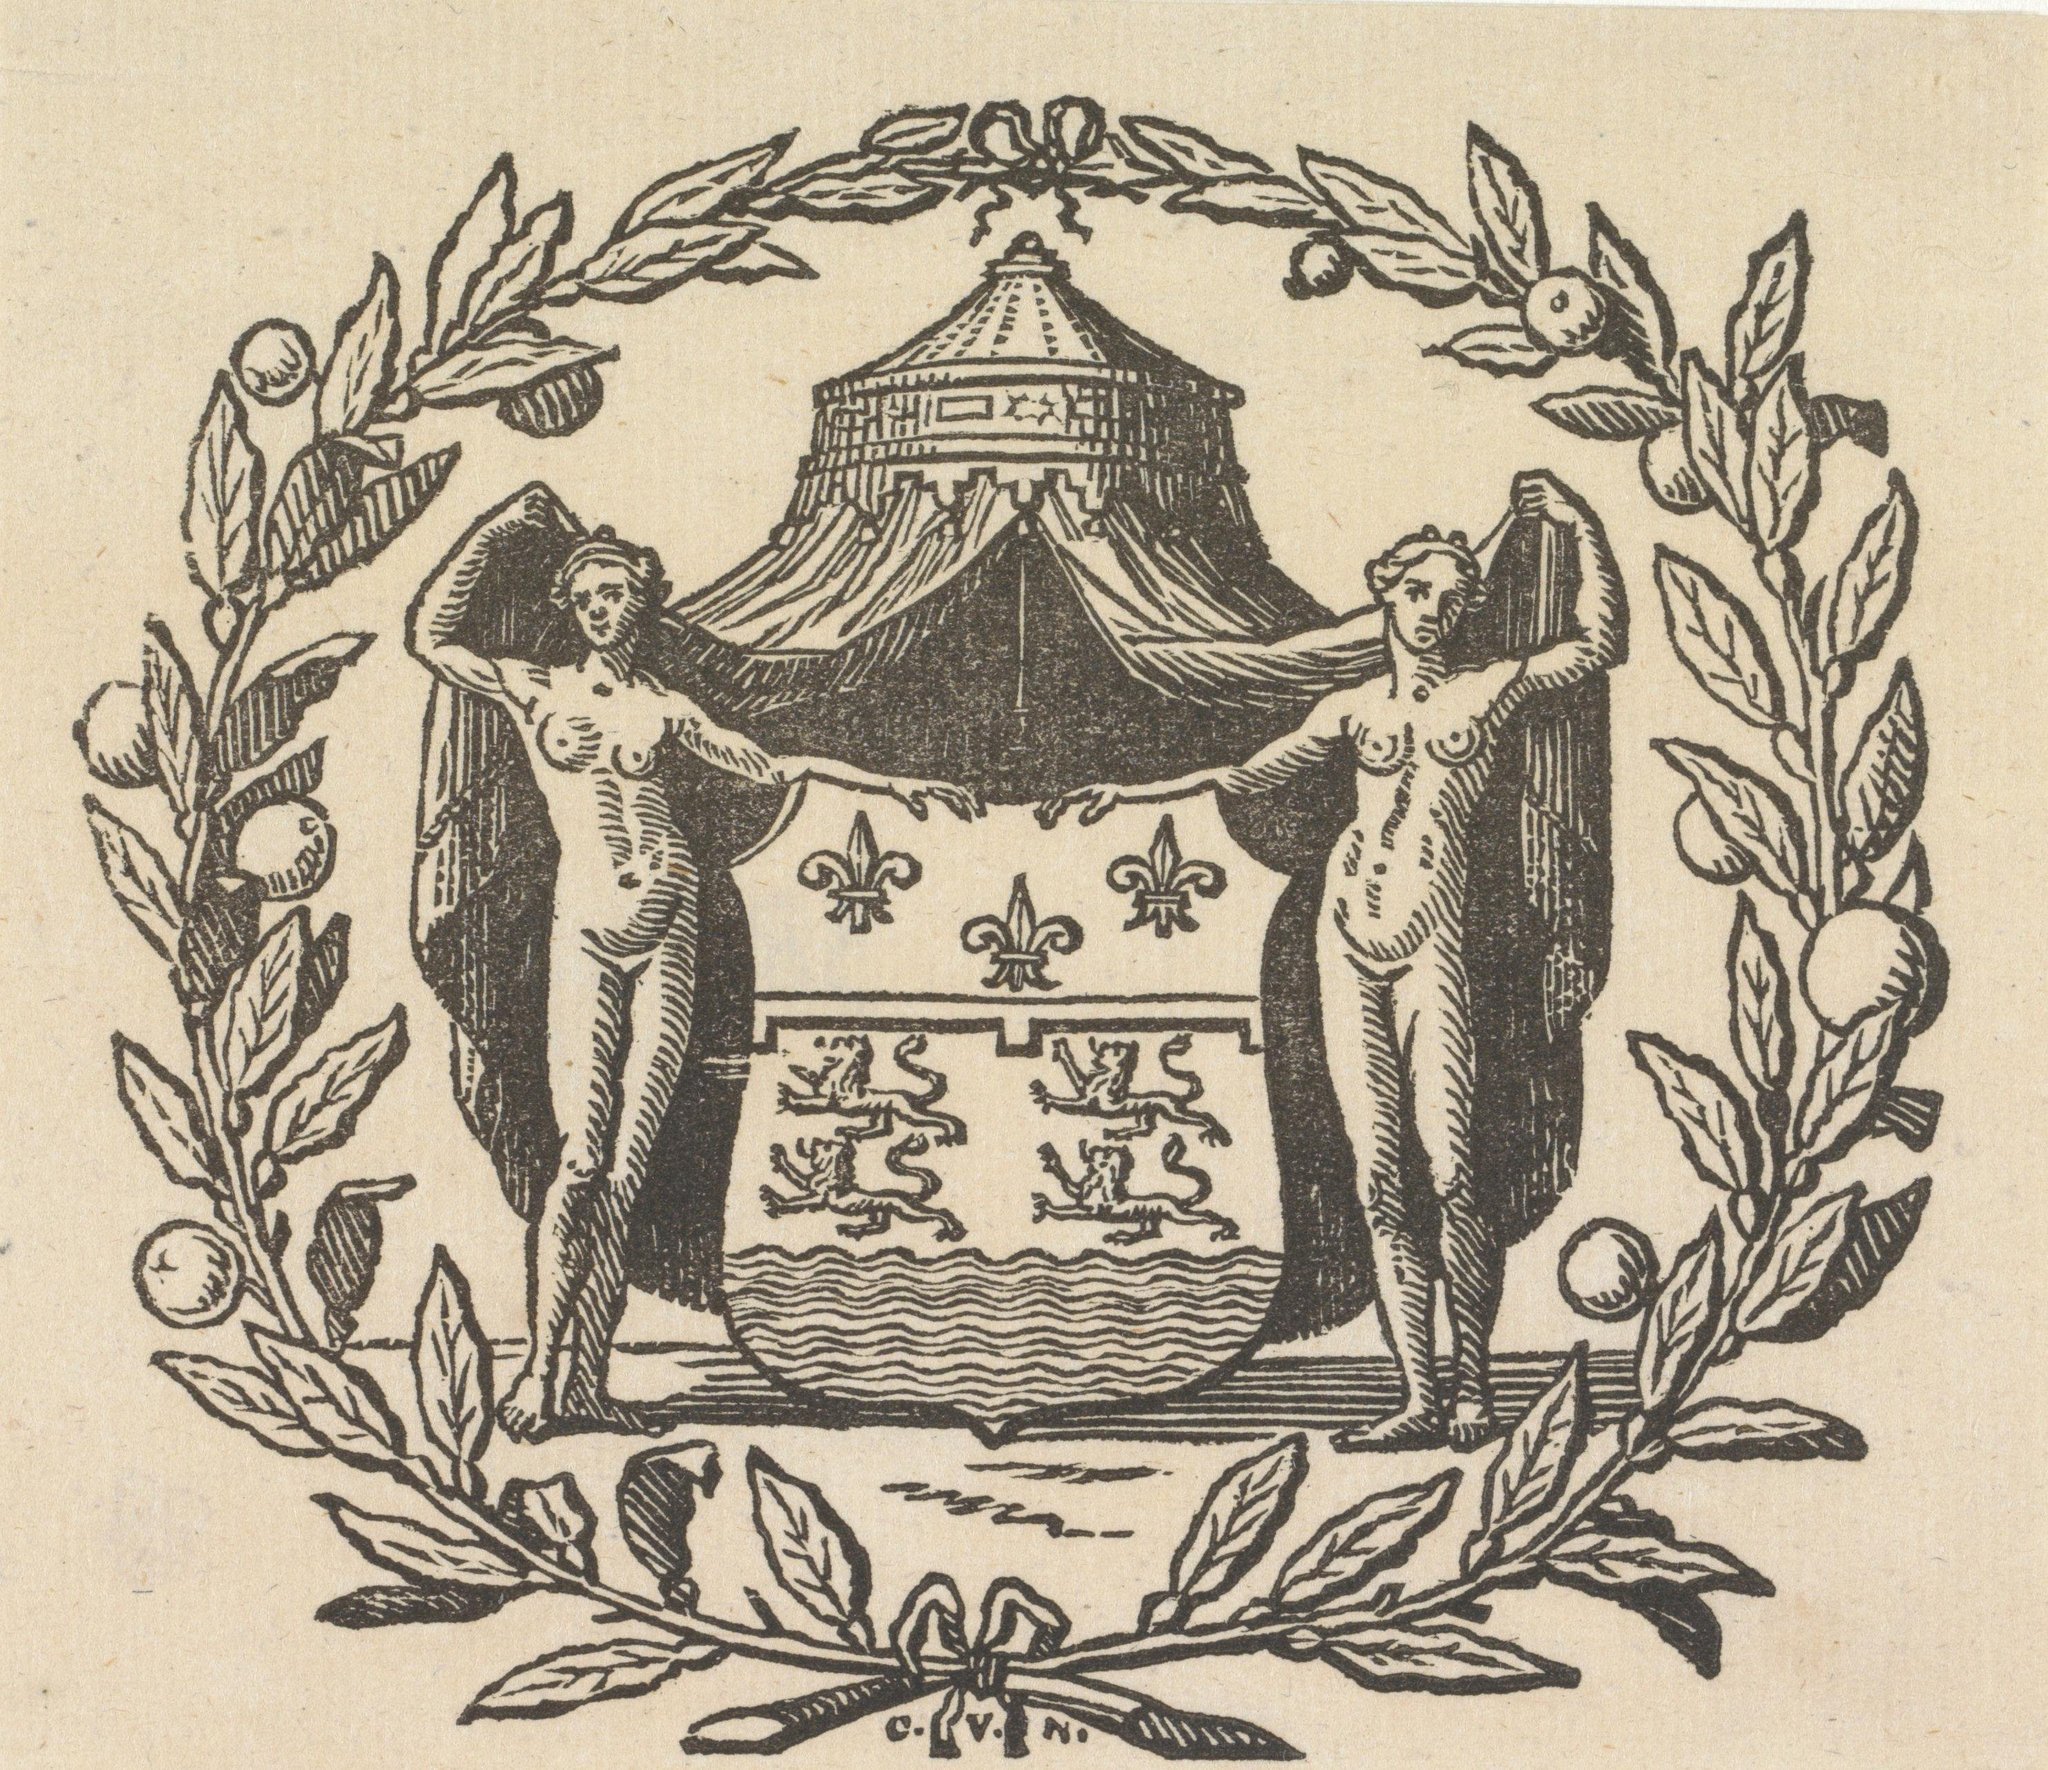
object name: print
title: Wapen met vier leeuwen en watergolven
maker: cornelis van noorde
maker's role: draughtsman, print maker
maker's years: 1731-1795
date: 1741-1795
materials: paper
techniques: woodcut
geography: haarlem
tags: wave, coat of arms (as symbol of the state, etc.), beasts of prey, predatory animals: lion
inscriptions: collector's mark: Lugt 2760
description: Het wapen van Beverwijk. Aan weerszijden van het wapen een allegorisch vrouwfiguur.